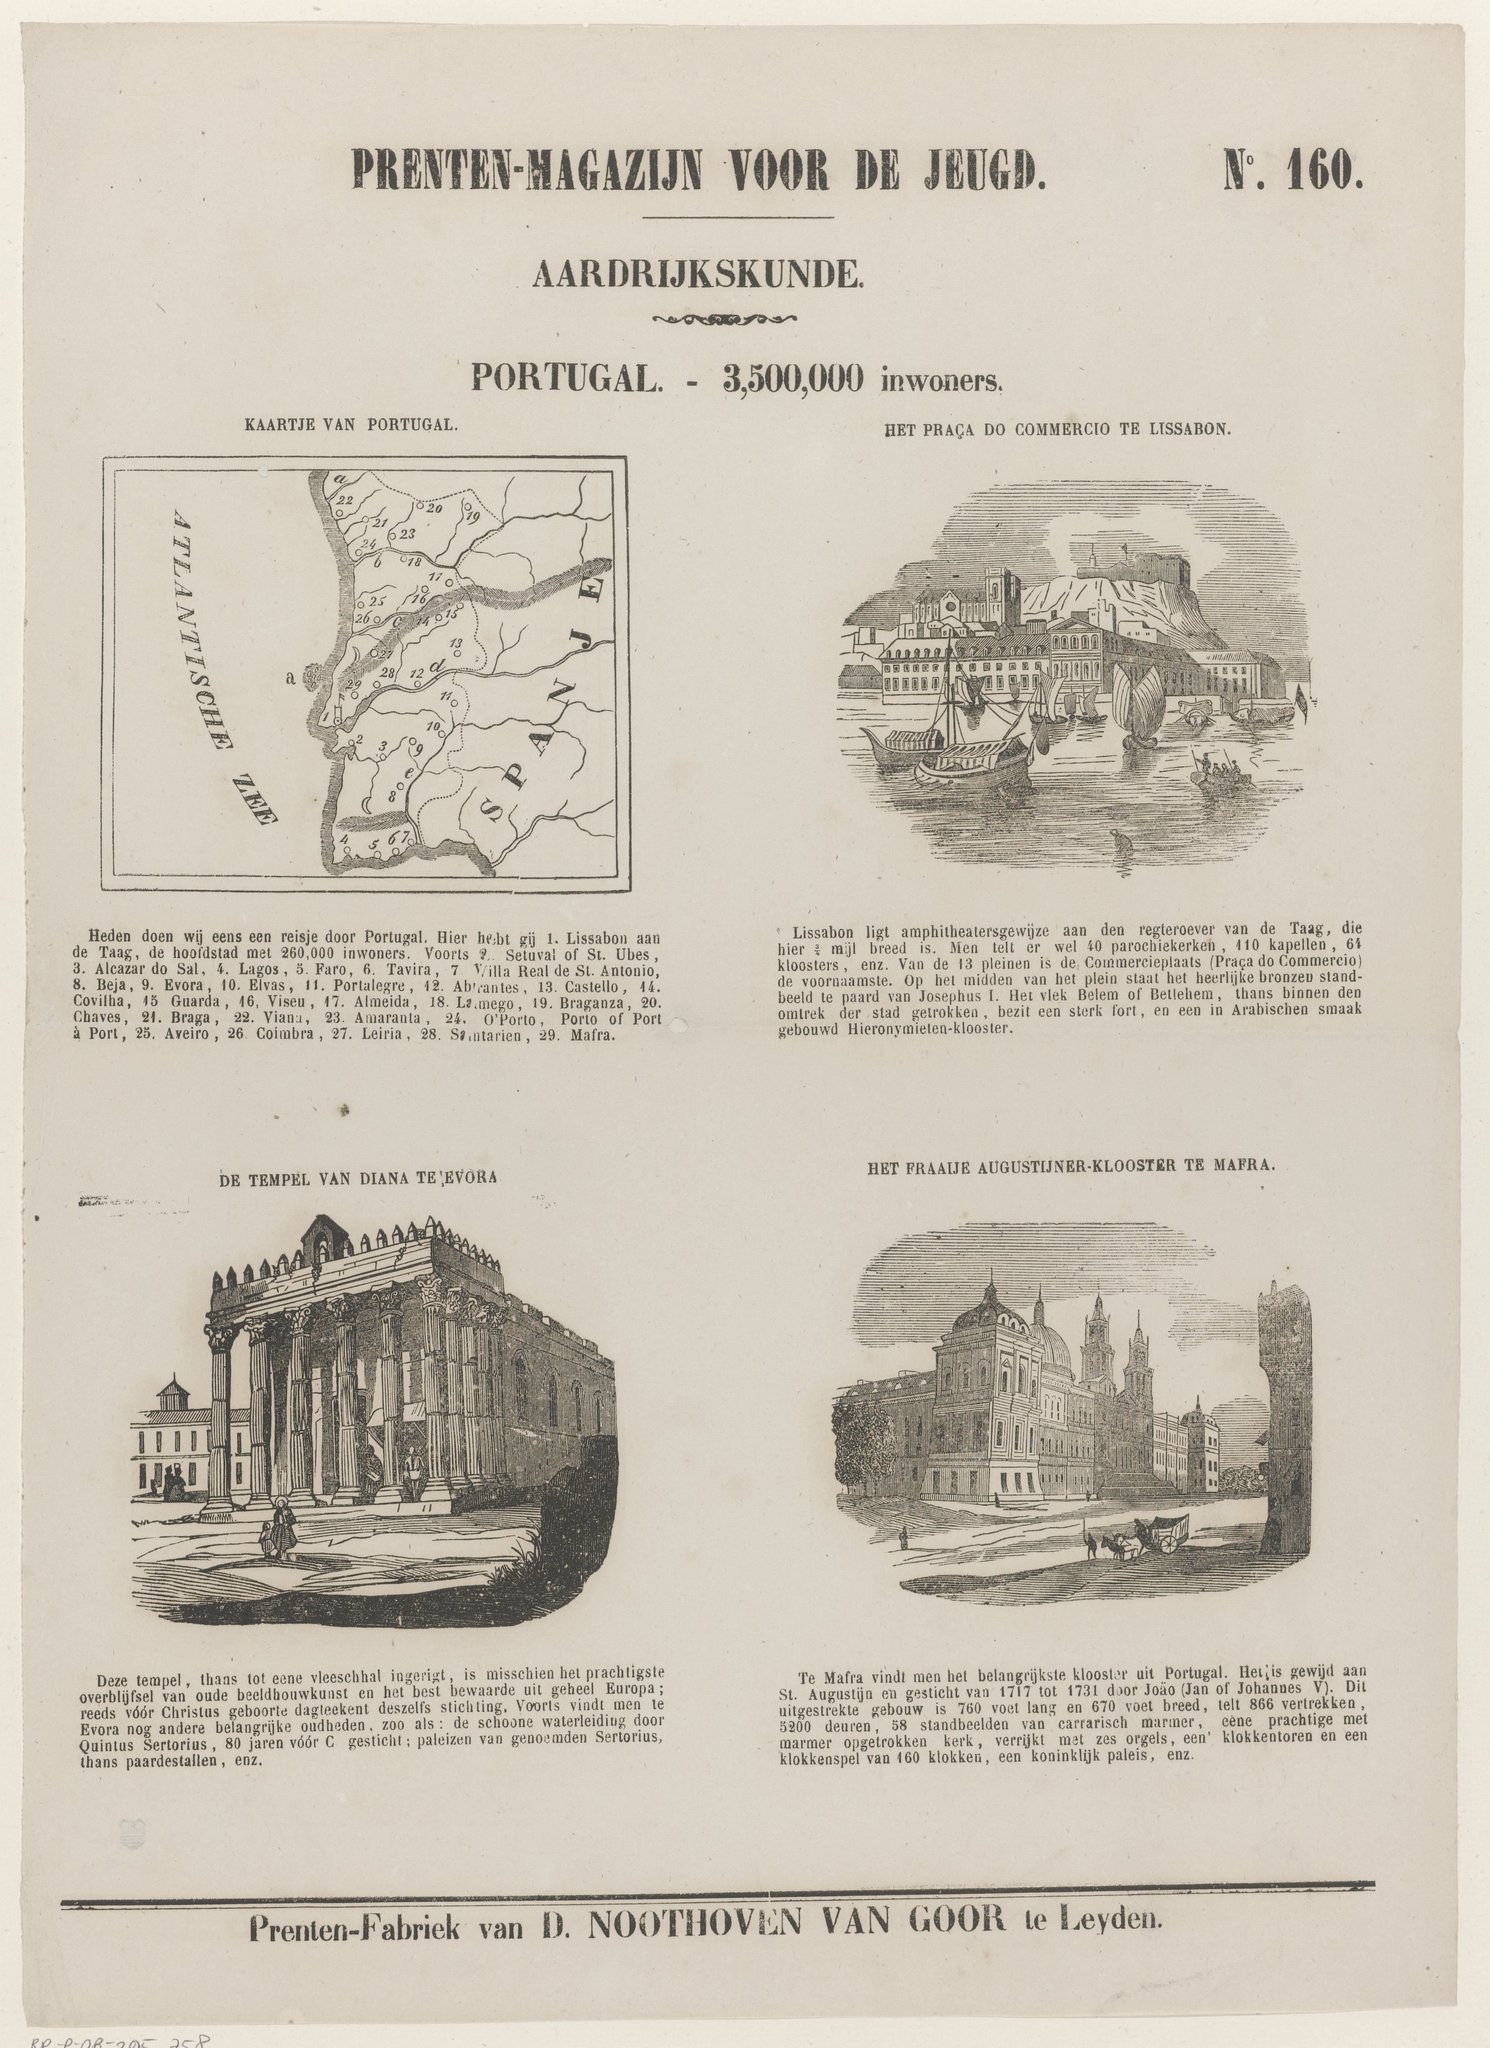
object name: print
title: Aardrijkskunde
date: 1850-1881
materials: paper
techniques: letterpress printing, engraving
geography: leiden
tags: maps, atlases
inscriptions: collector's mark: Lugt 2760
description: Blad met 4 voorstellingen over Portugal met een kaart en belangrijke gebouwen: het Praça do Comércio in Lissabon, de Romeinse tempel in Évora en het Paleis van Mafra. Boven elke voorstelling een titel en onder elke voorstelling een onderschrift. Genummerd rechtsboven: No. 160.